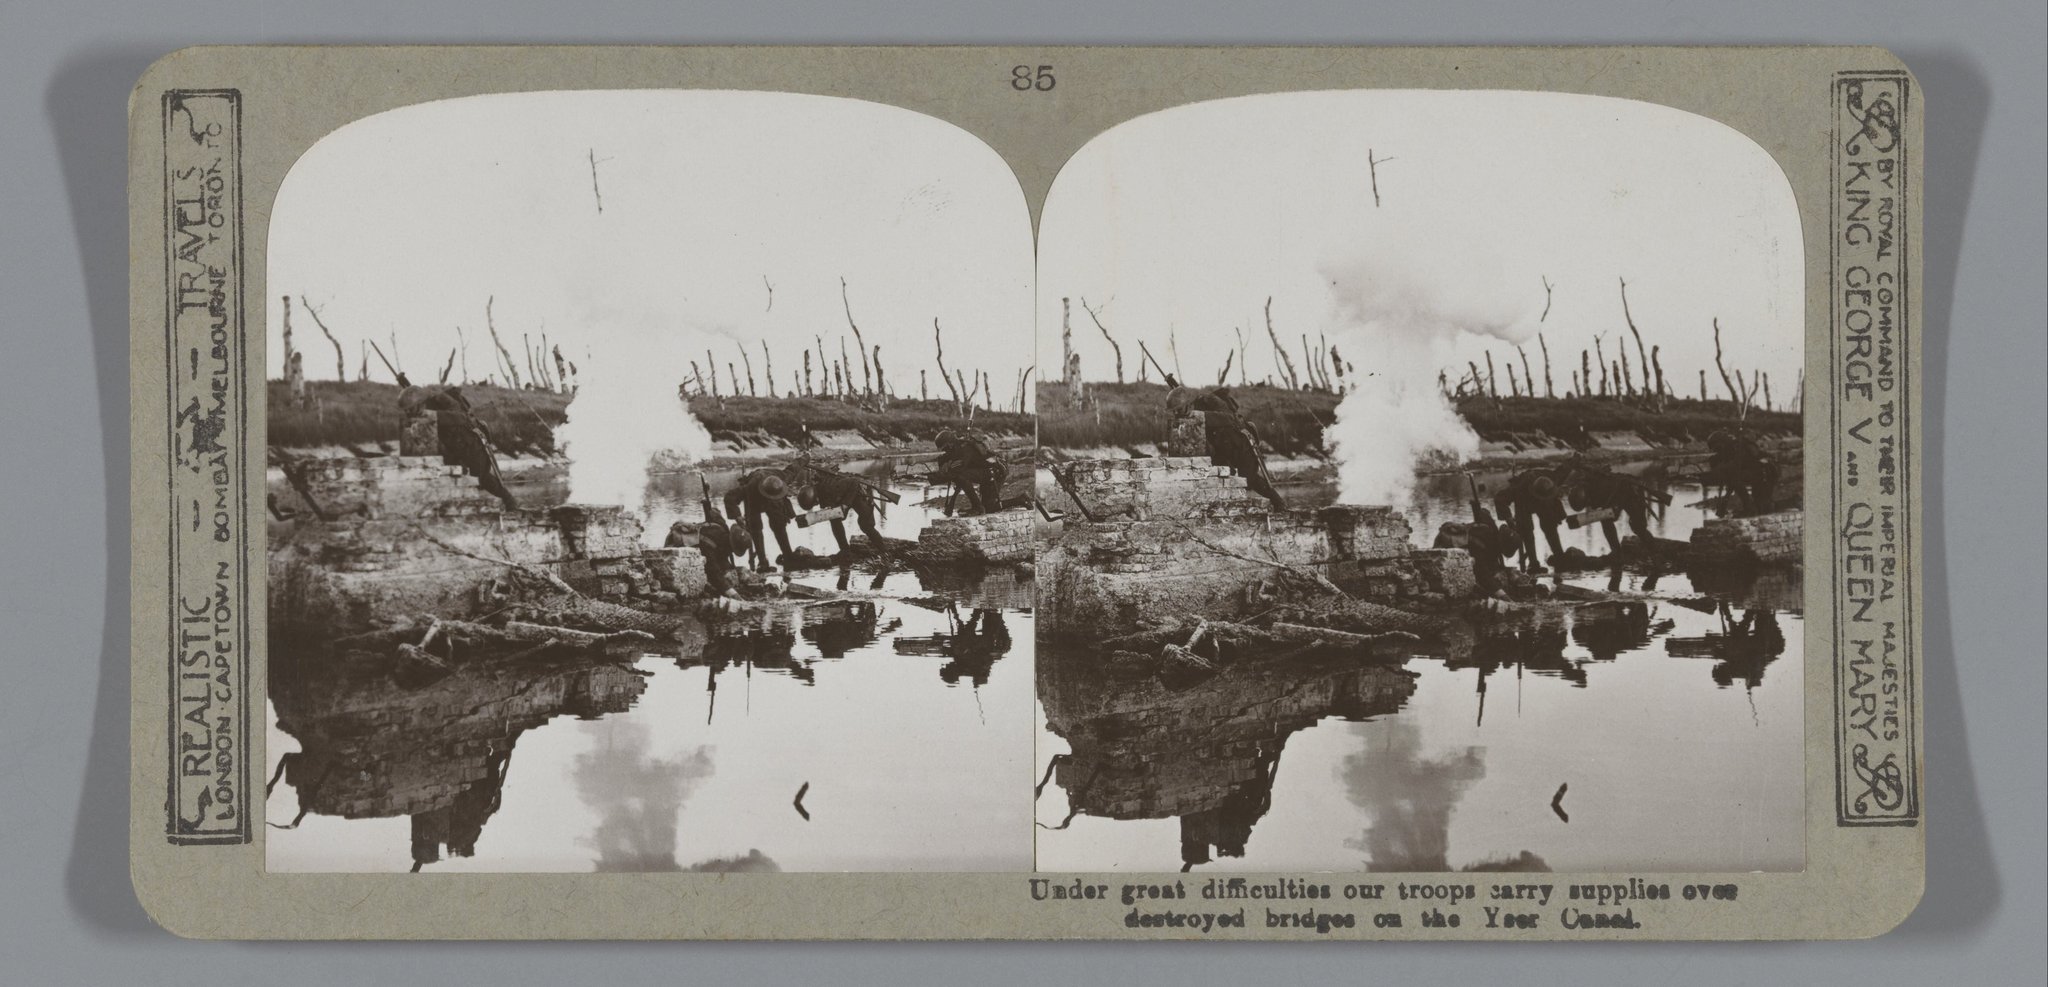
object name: stereograph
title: Under great difficulties our troops carry supplies over destroyed bridges on the Yser Canal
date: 1914-1918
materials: cardboard, photographic support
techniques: gelatin silver print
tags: river, private soldier, (military) equipment and supply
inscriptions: number: ‘85’, inscription: ‘By Royal command to their Imperial majesties King George V and Queen Mary’